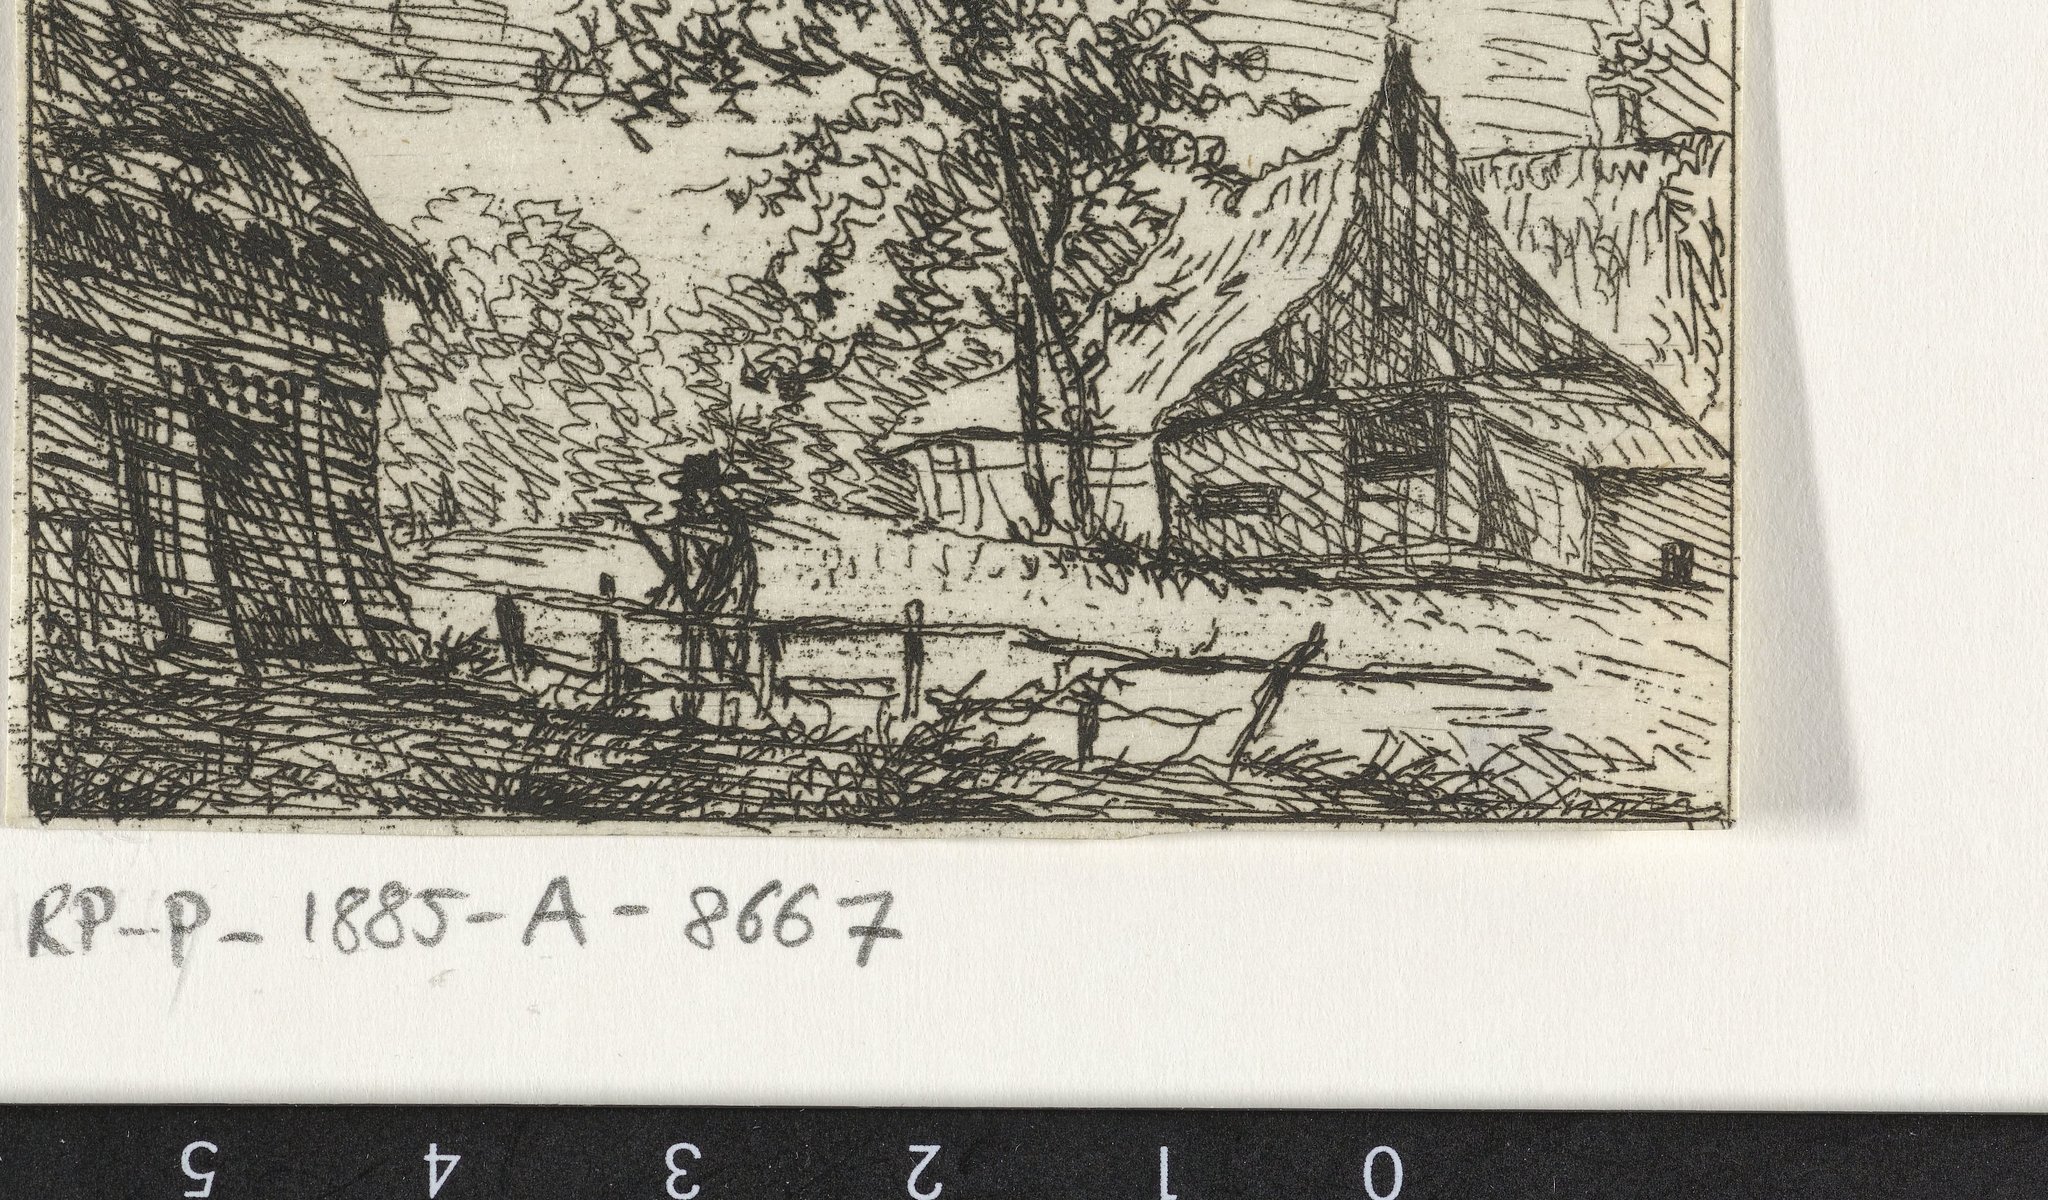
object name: print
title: Landschap met man bij een schutting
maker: anthony oberman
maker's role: draughtsman, painter, print maker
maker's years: 1781-1845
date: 1796-1845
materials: paper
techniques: etching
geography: amsterdam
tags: landscapes in the temperate zone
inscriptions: collector's mark: Lugt 2228